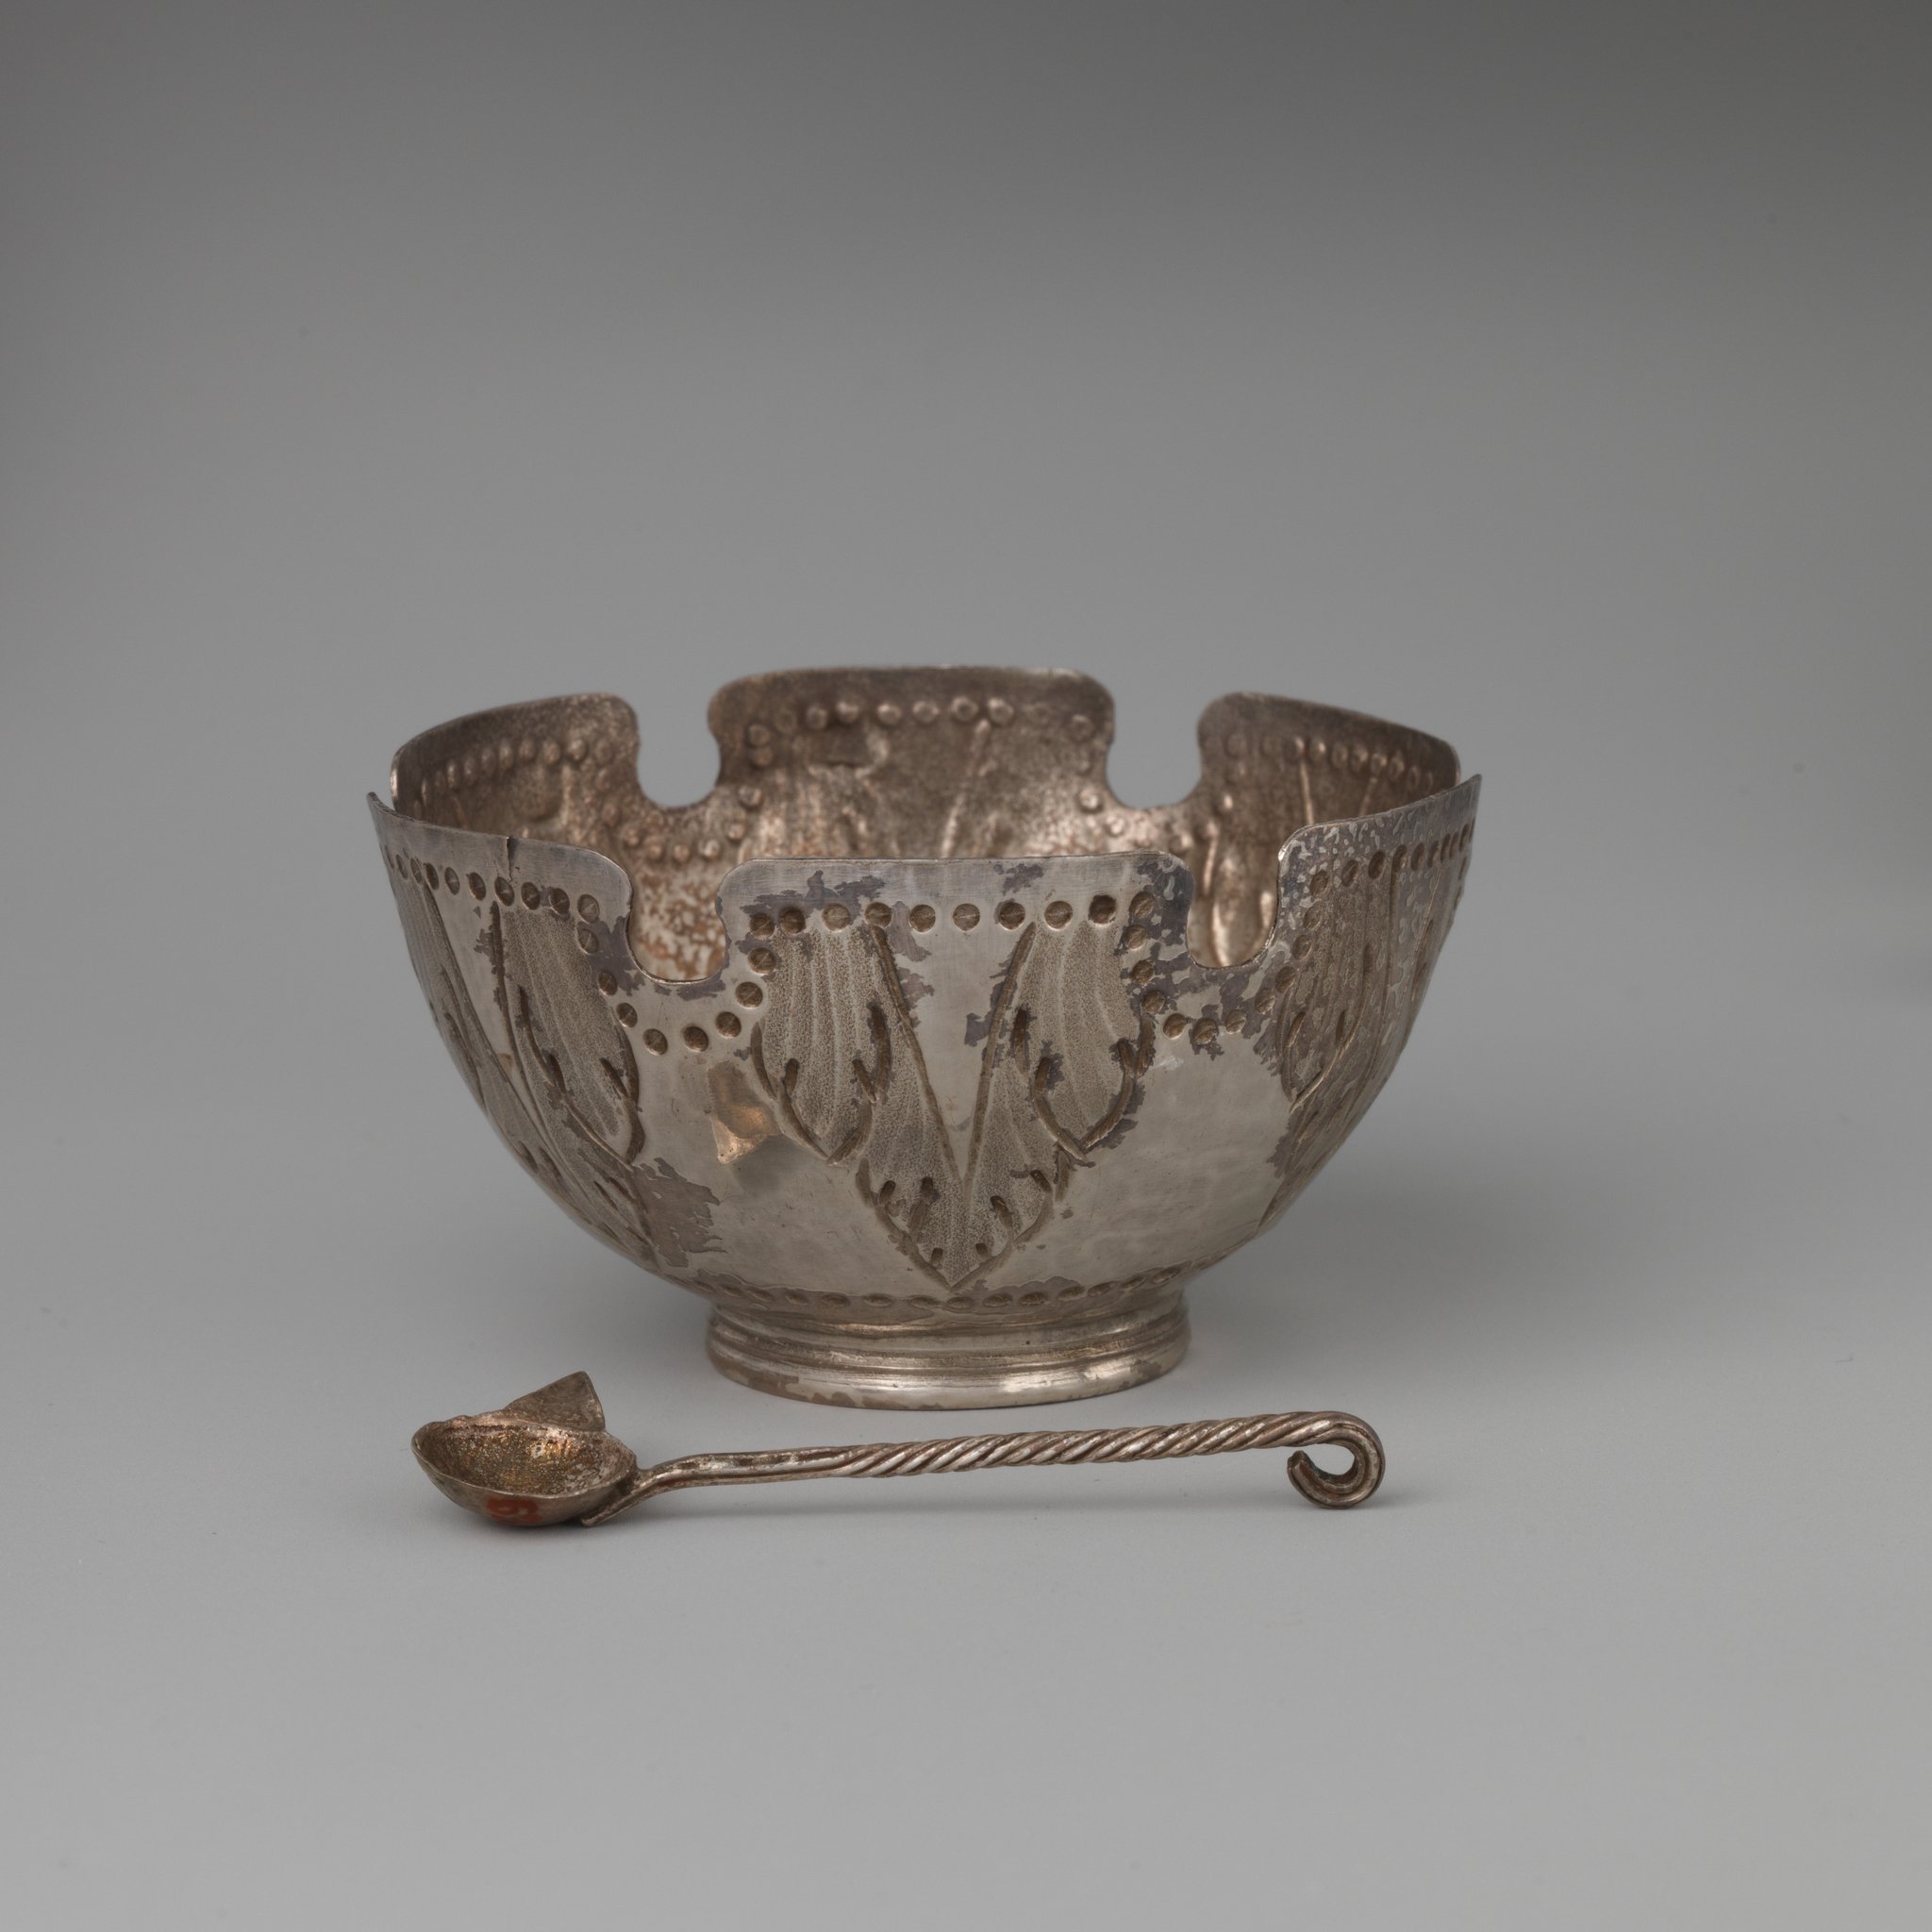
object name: ladle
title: Miniature ladle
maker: george manjoy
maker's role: maker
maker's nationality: british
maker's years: 1685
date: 1693-1694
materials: silver